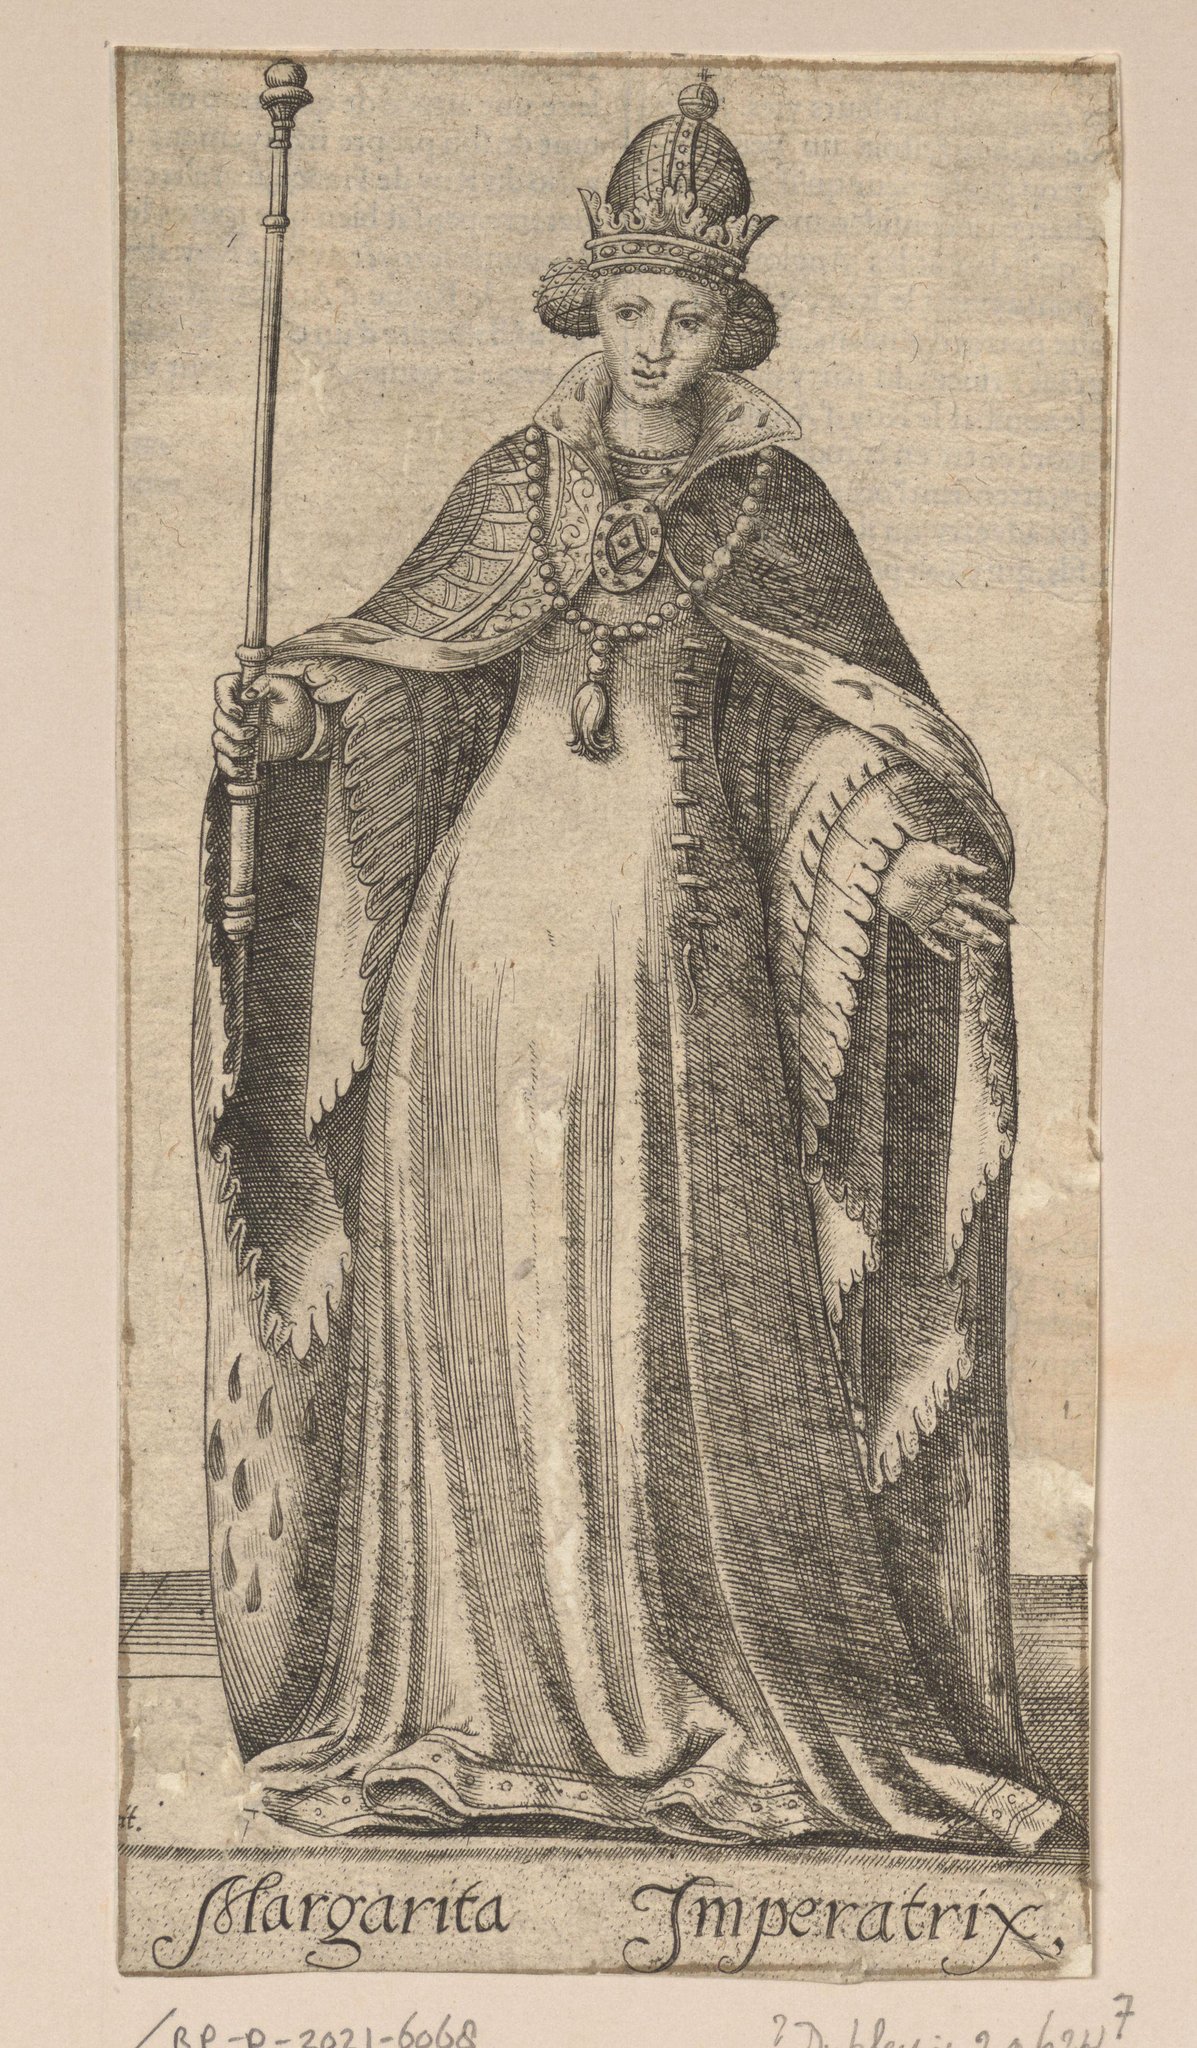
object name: book illustration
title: Portret van Margaretha II van Henegouwen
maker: Anonymous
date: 1570-1650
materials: paper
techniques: engraving, letterpress printing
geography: low countries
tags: sceptre, staff (symbol of sovereignty) - bb - female ruler, historical persons - bb - woman, crown (symbol of sovereignty) - bb - female ruler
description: Prent komt uit een onbekende publicatie. Een vergelijkbaar portret is gebruikt in: Vosmeer, Michel. Principes Hollandiae et Zelandiae, domini Frisiae. Antwerpen: Christoffel Plantijn, 1578.